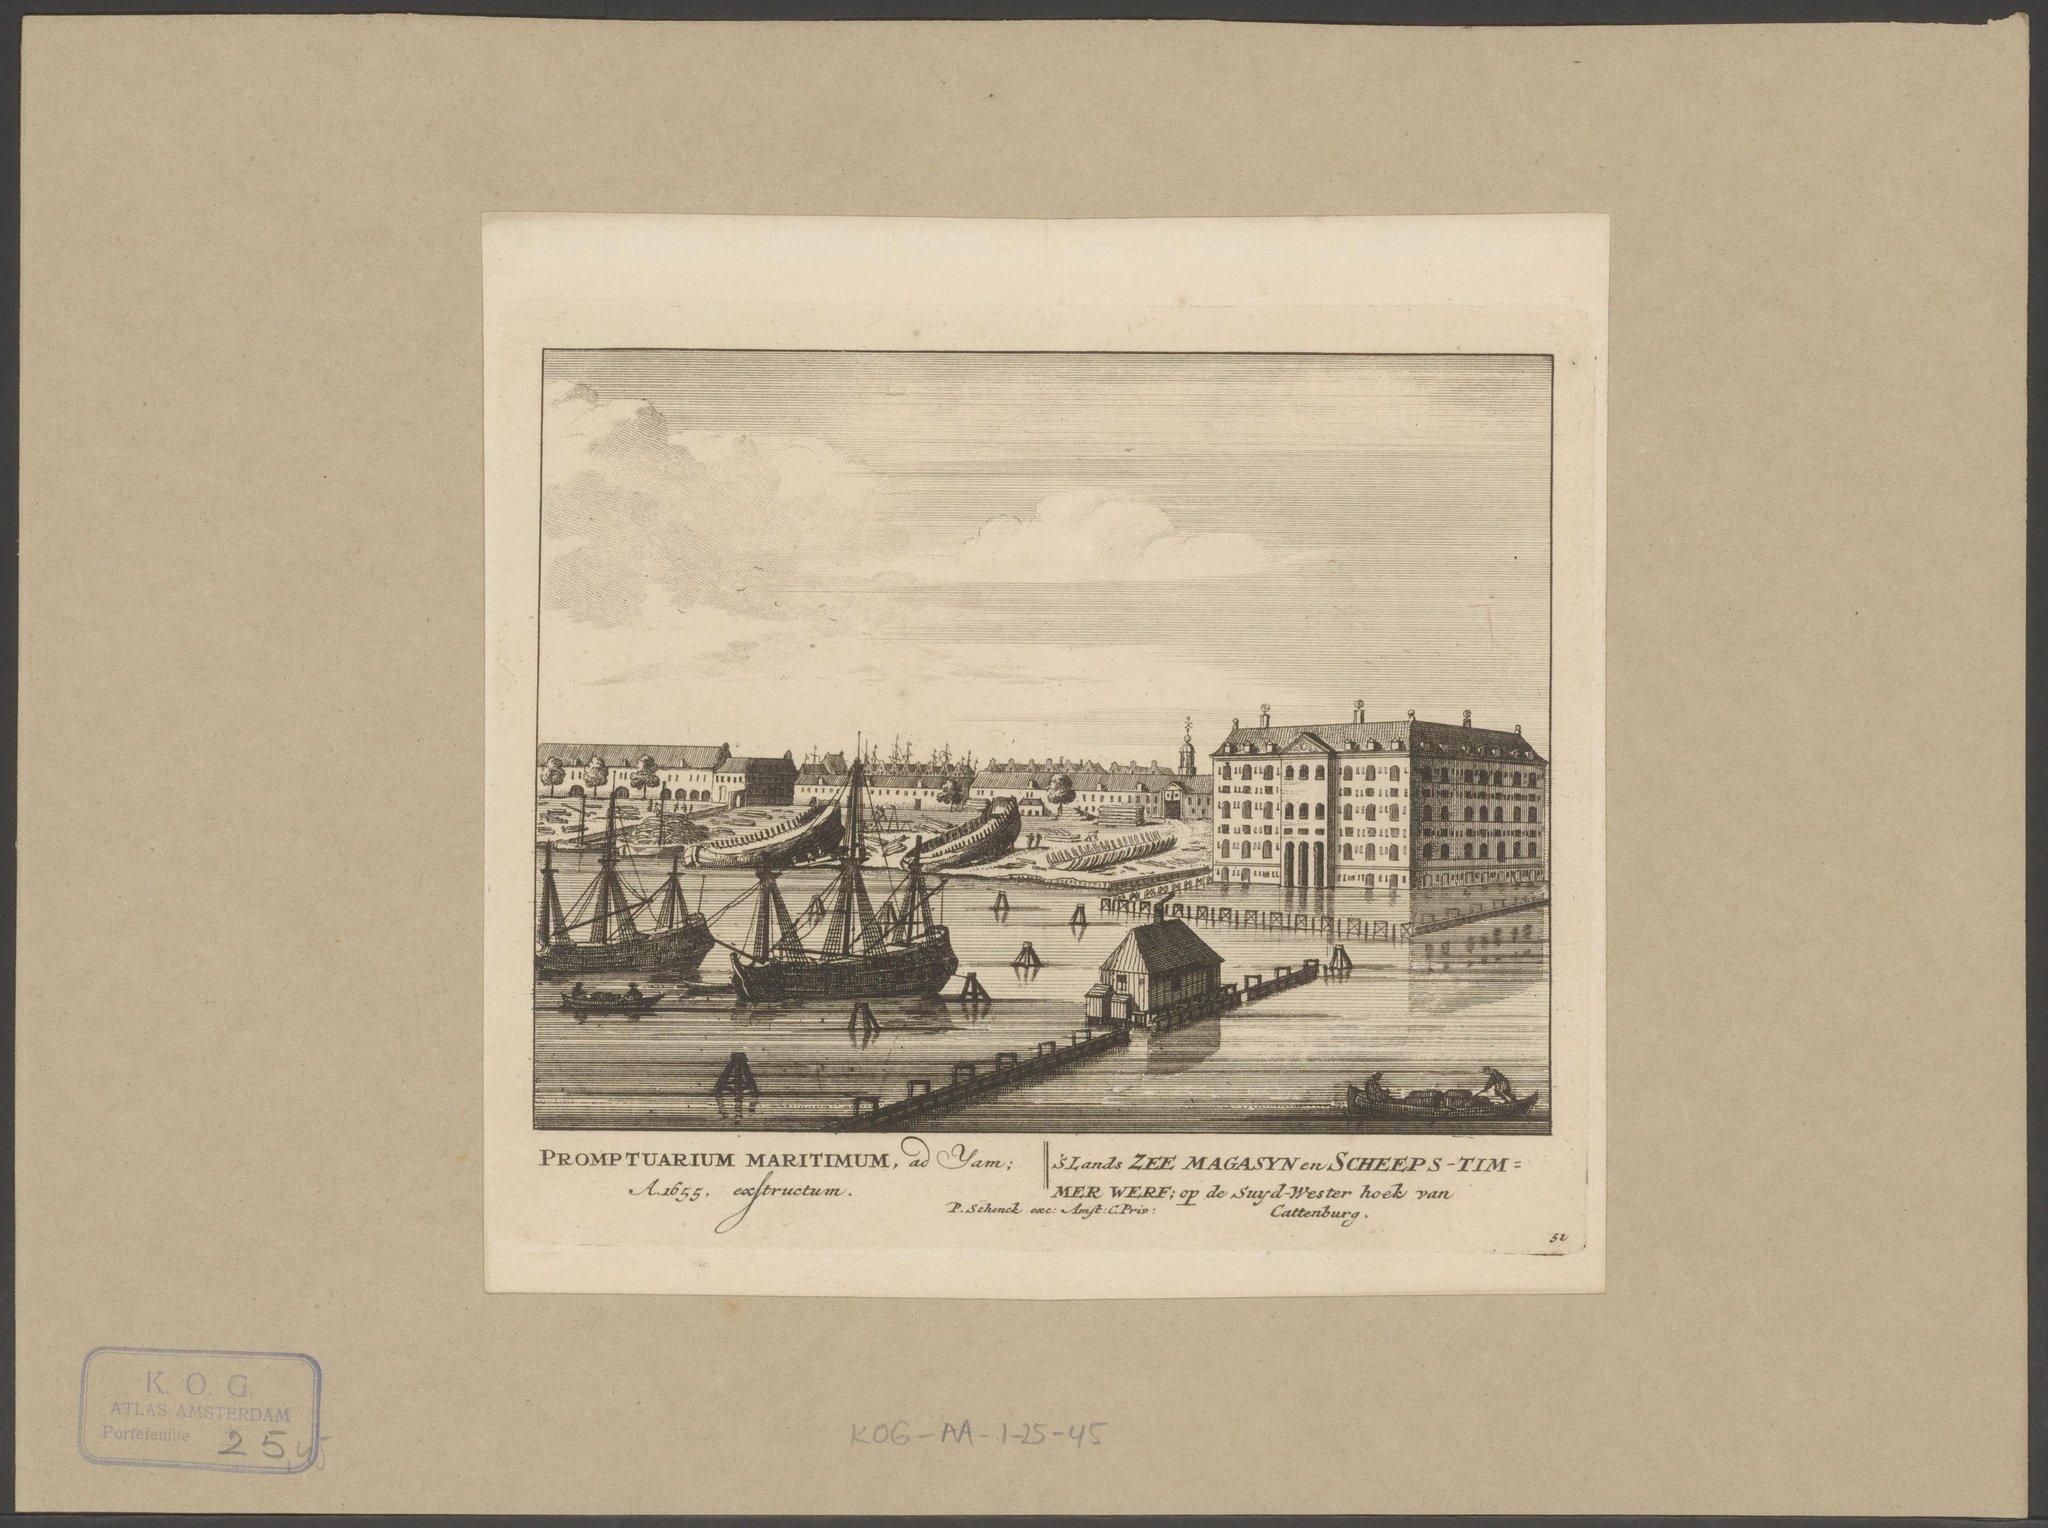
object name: print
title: 's Lands Zee Magasyn en Scheeps-timmer werf; op de suyd-wester hoek van Cattenburg / Promptuarium Maritimum, ad yam; A. 1655. exstructum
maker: Anonymous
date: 1710-1711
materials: paper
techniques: engraving, etching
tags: large-scale structure for storage, e.g.: warehouse, depot, silo, shipyard, shipdock, ammunition store, arsenal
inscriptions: collector's mark: ‘25.45’ Lugt 1641b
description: Huidige staat van prent ook gebruikt in: 100 Afbeeldinge der voornaamste gebouwen van Amsterdam. Amsterdam, Pieter Schenk (I), [1710-1711]. En in: 100 Afbeeldinge der voornaamste gebouwen van Amsterdam. Amsterdam, Barent Greve, s.a. [1757-1766].* *In de tweede uitgave, uitgegeven door Barent Greve, is alleen de titelprent aangepast. De overige prenten zijn onveranderd gebleven.